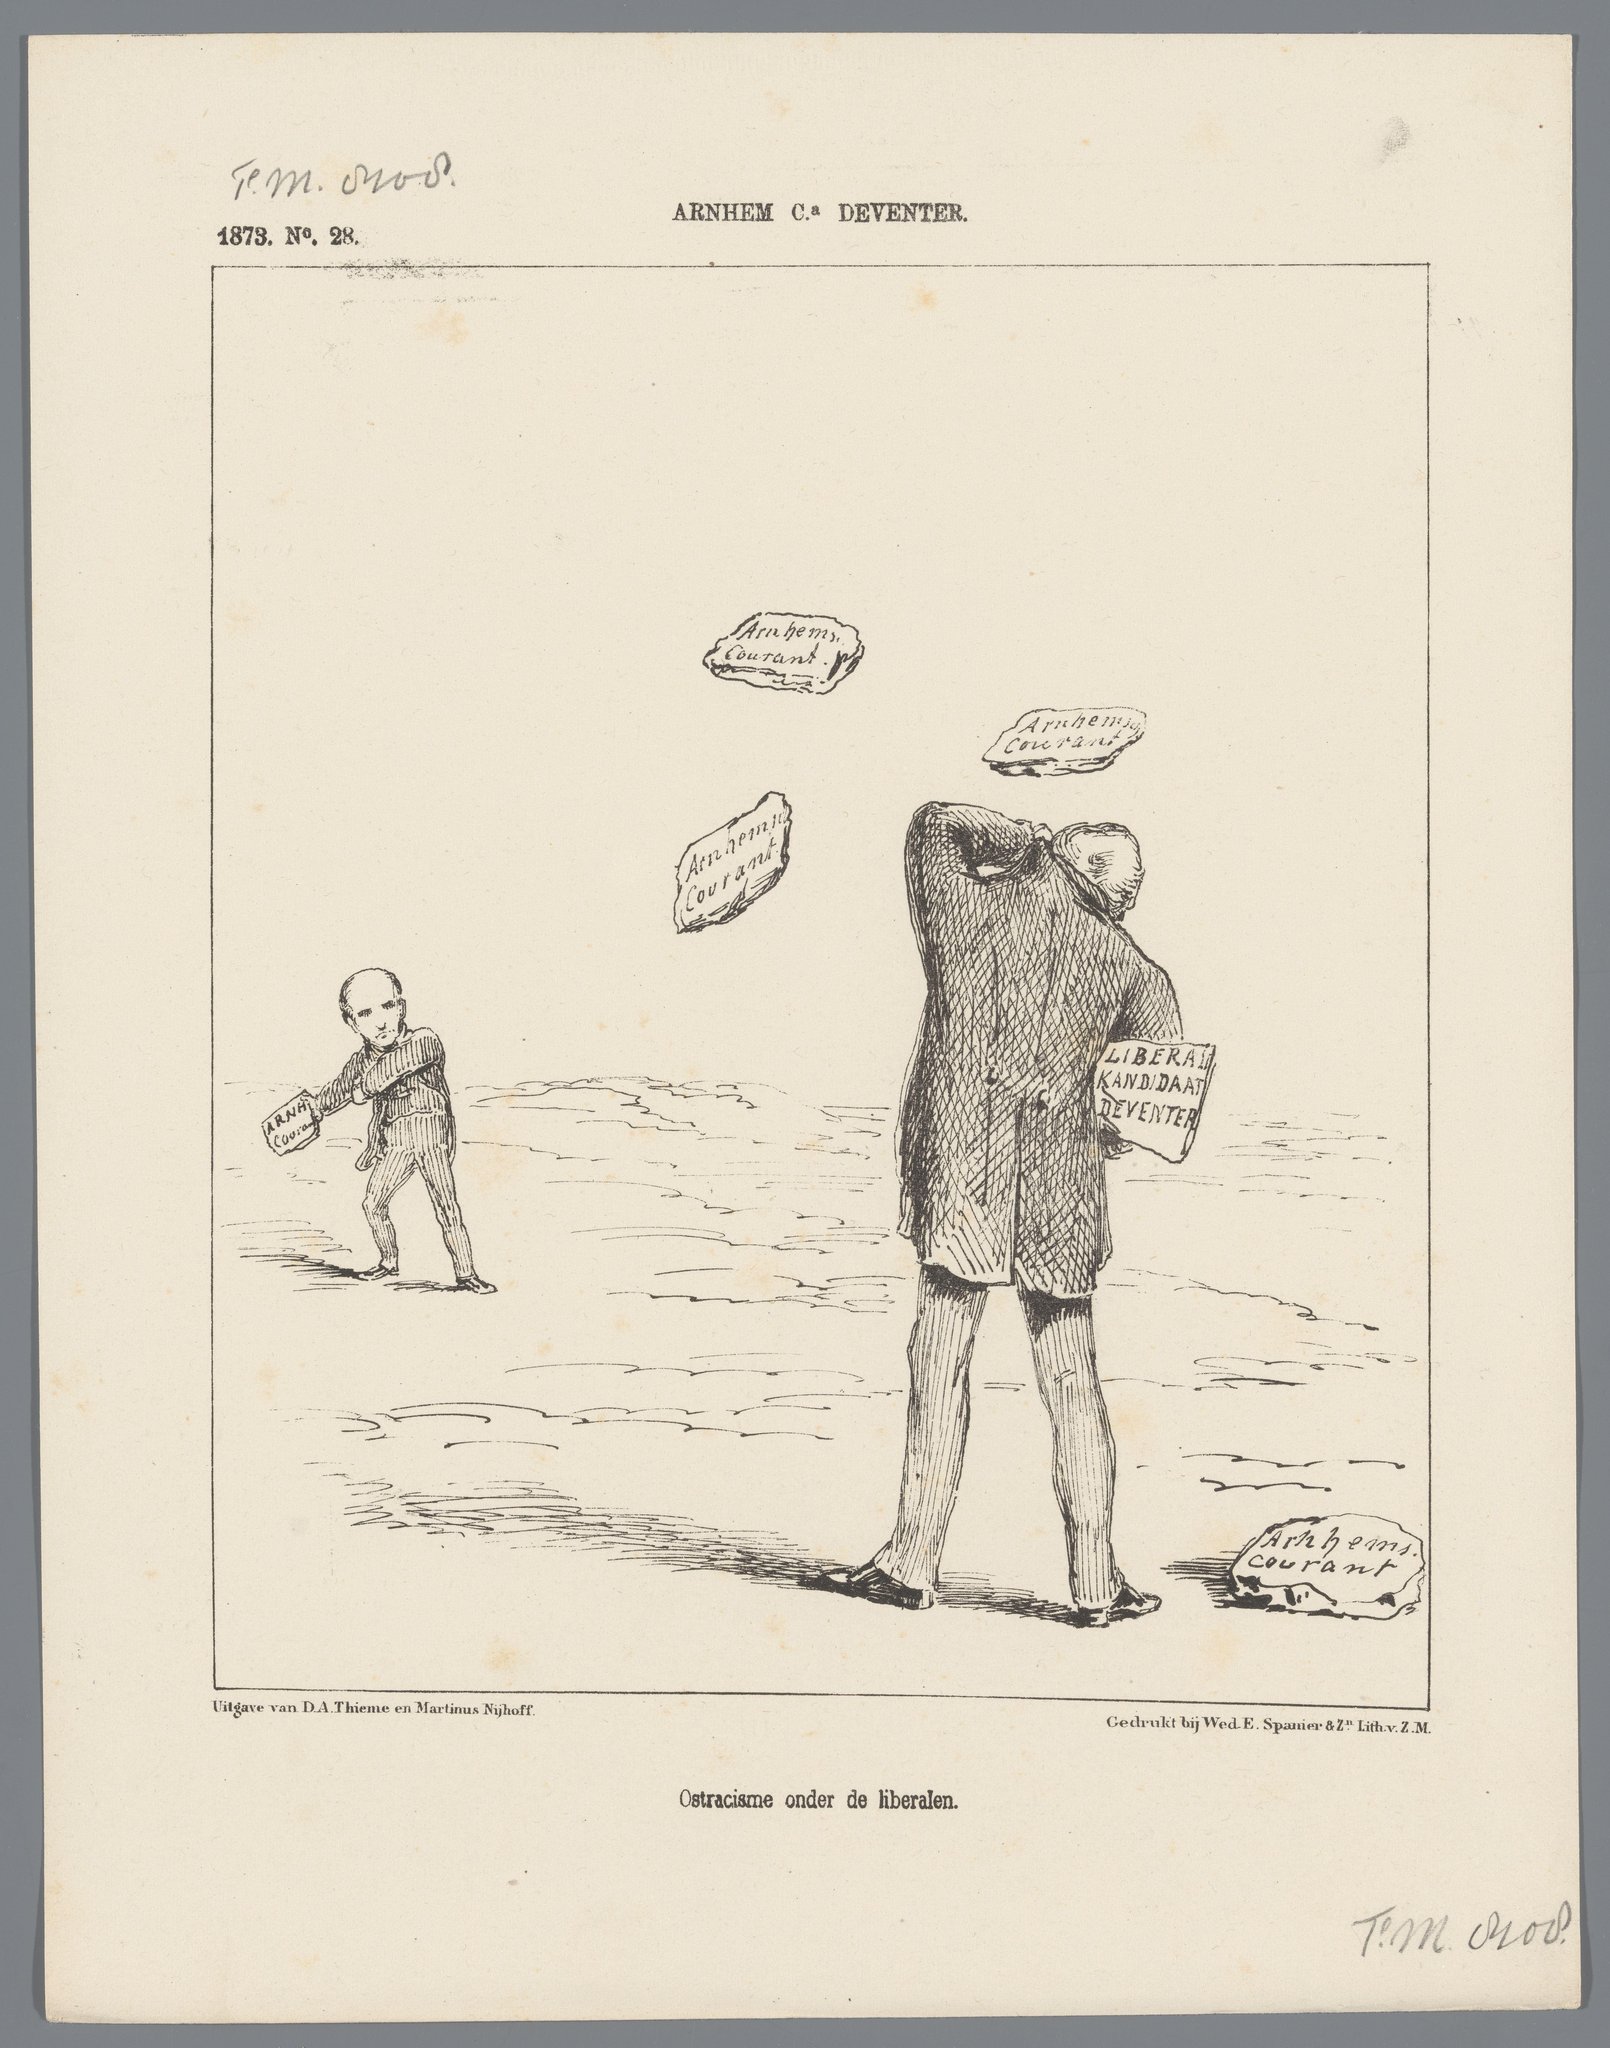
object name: cartoon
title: Arnhem C.a Deventer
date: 1873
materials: paper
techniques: lithograph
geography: netherlands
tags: deventer, arnhem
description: Spotprent op de Arnhemsche Courant en de verkiezingen te Deventer. Plaat verschenen bij het weekblad De Nederlandsche Spectator, nr. 28, 1873.